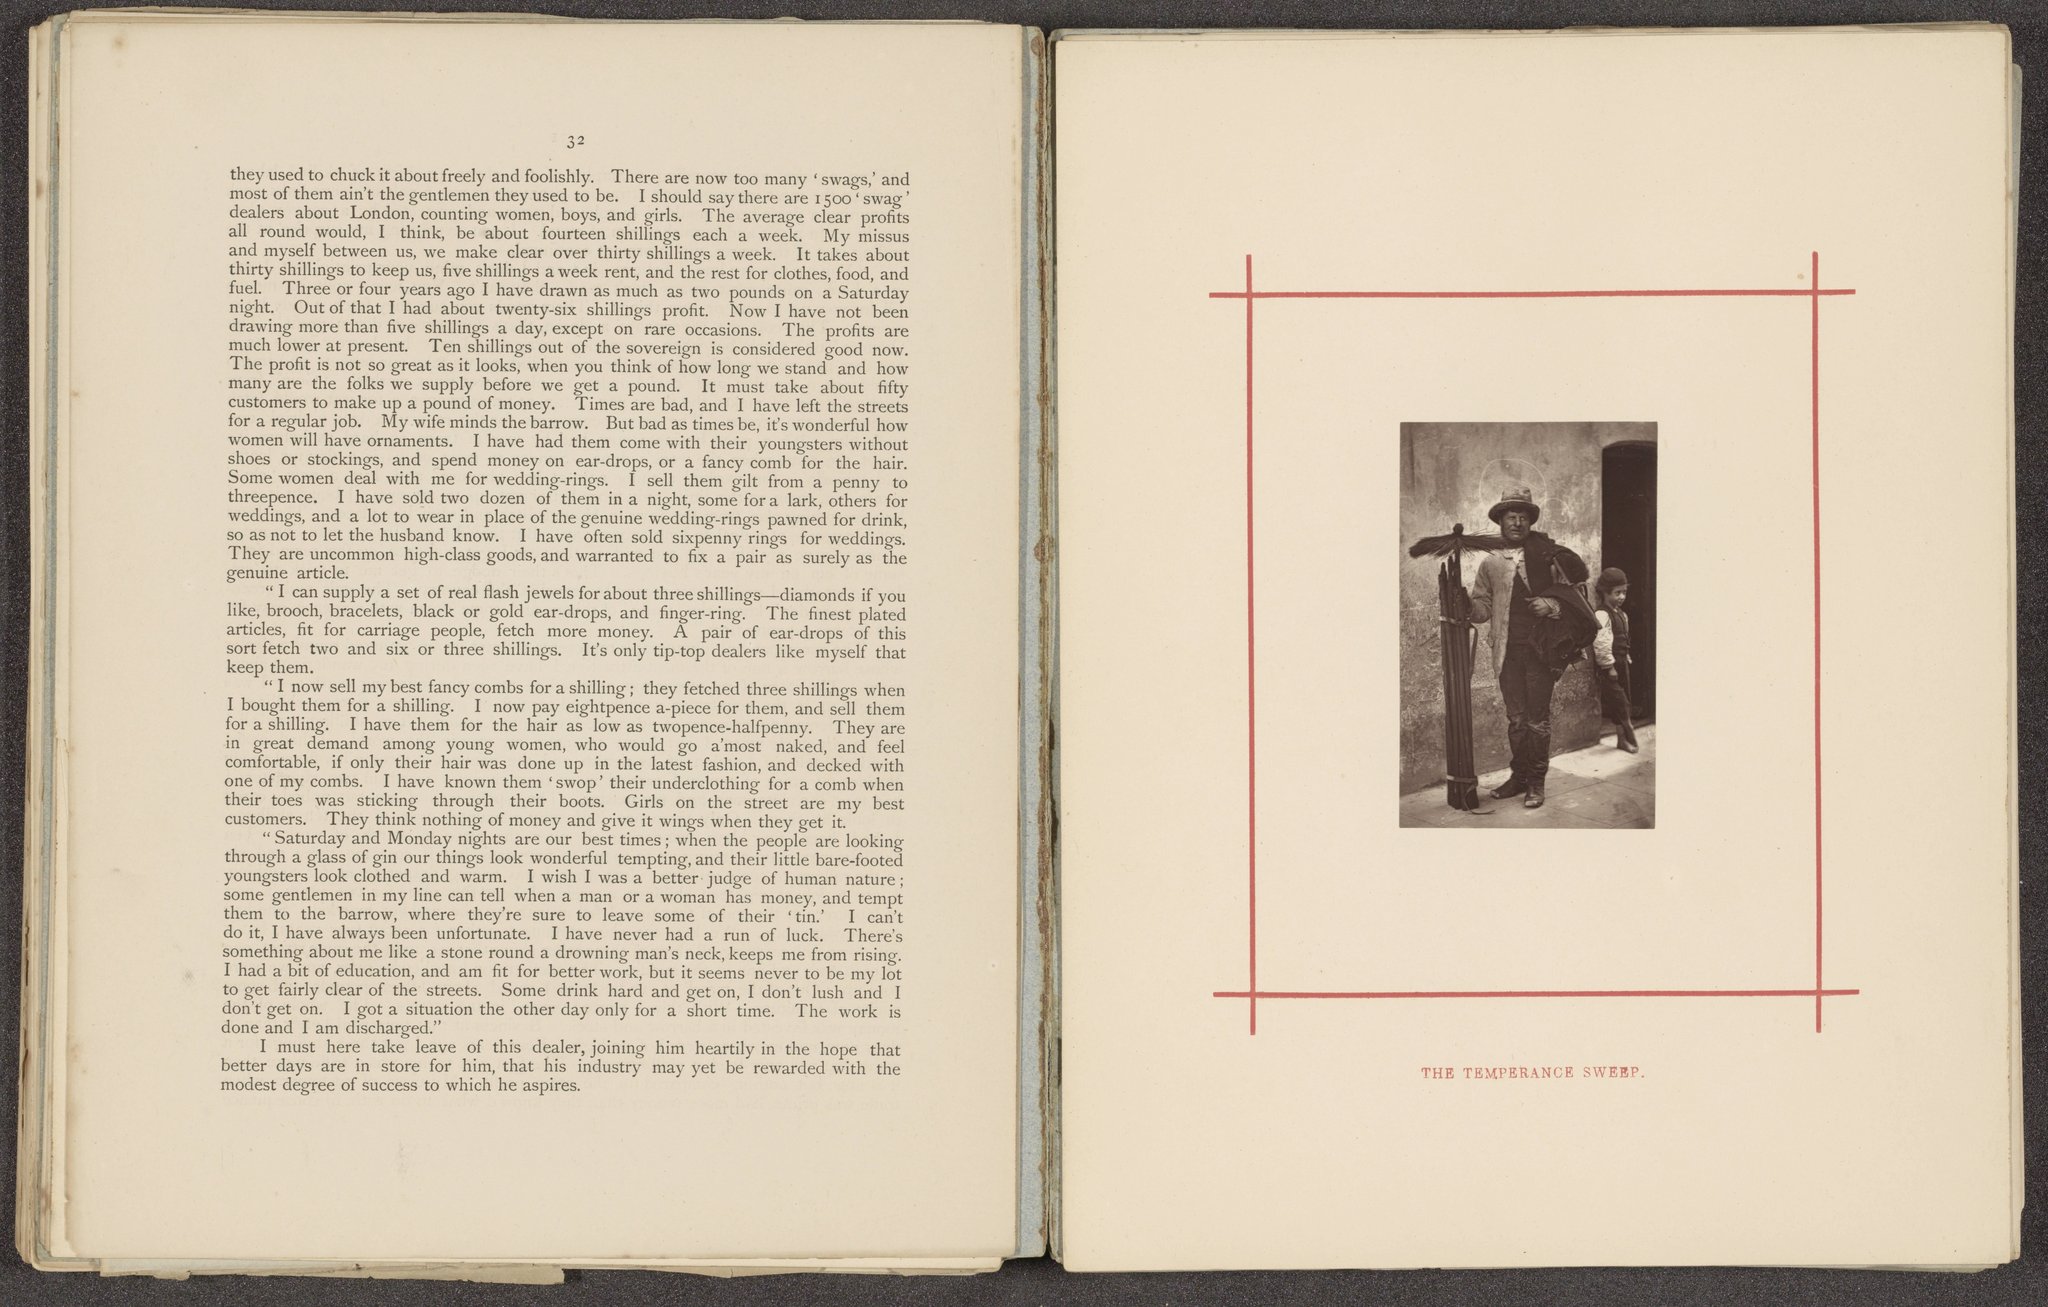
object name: photomechanical print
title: The temperance sweep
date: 1876-1877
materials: paper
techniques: woodburytype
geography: london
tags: handicrafts ~ maintenance and repair (with name of trade or profession), london